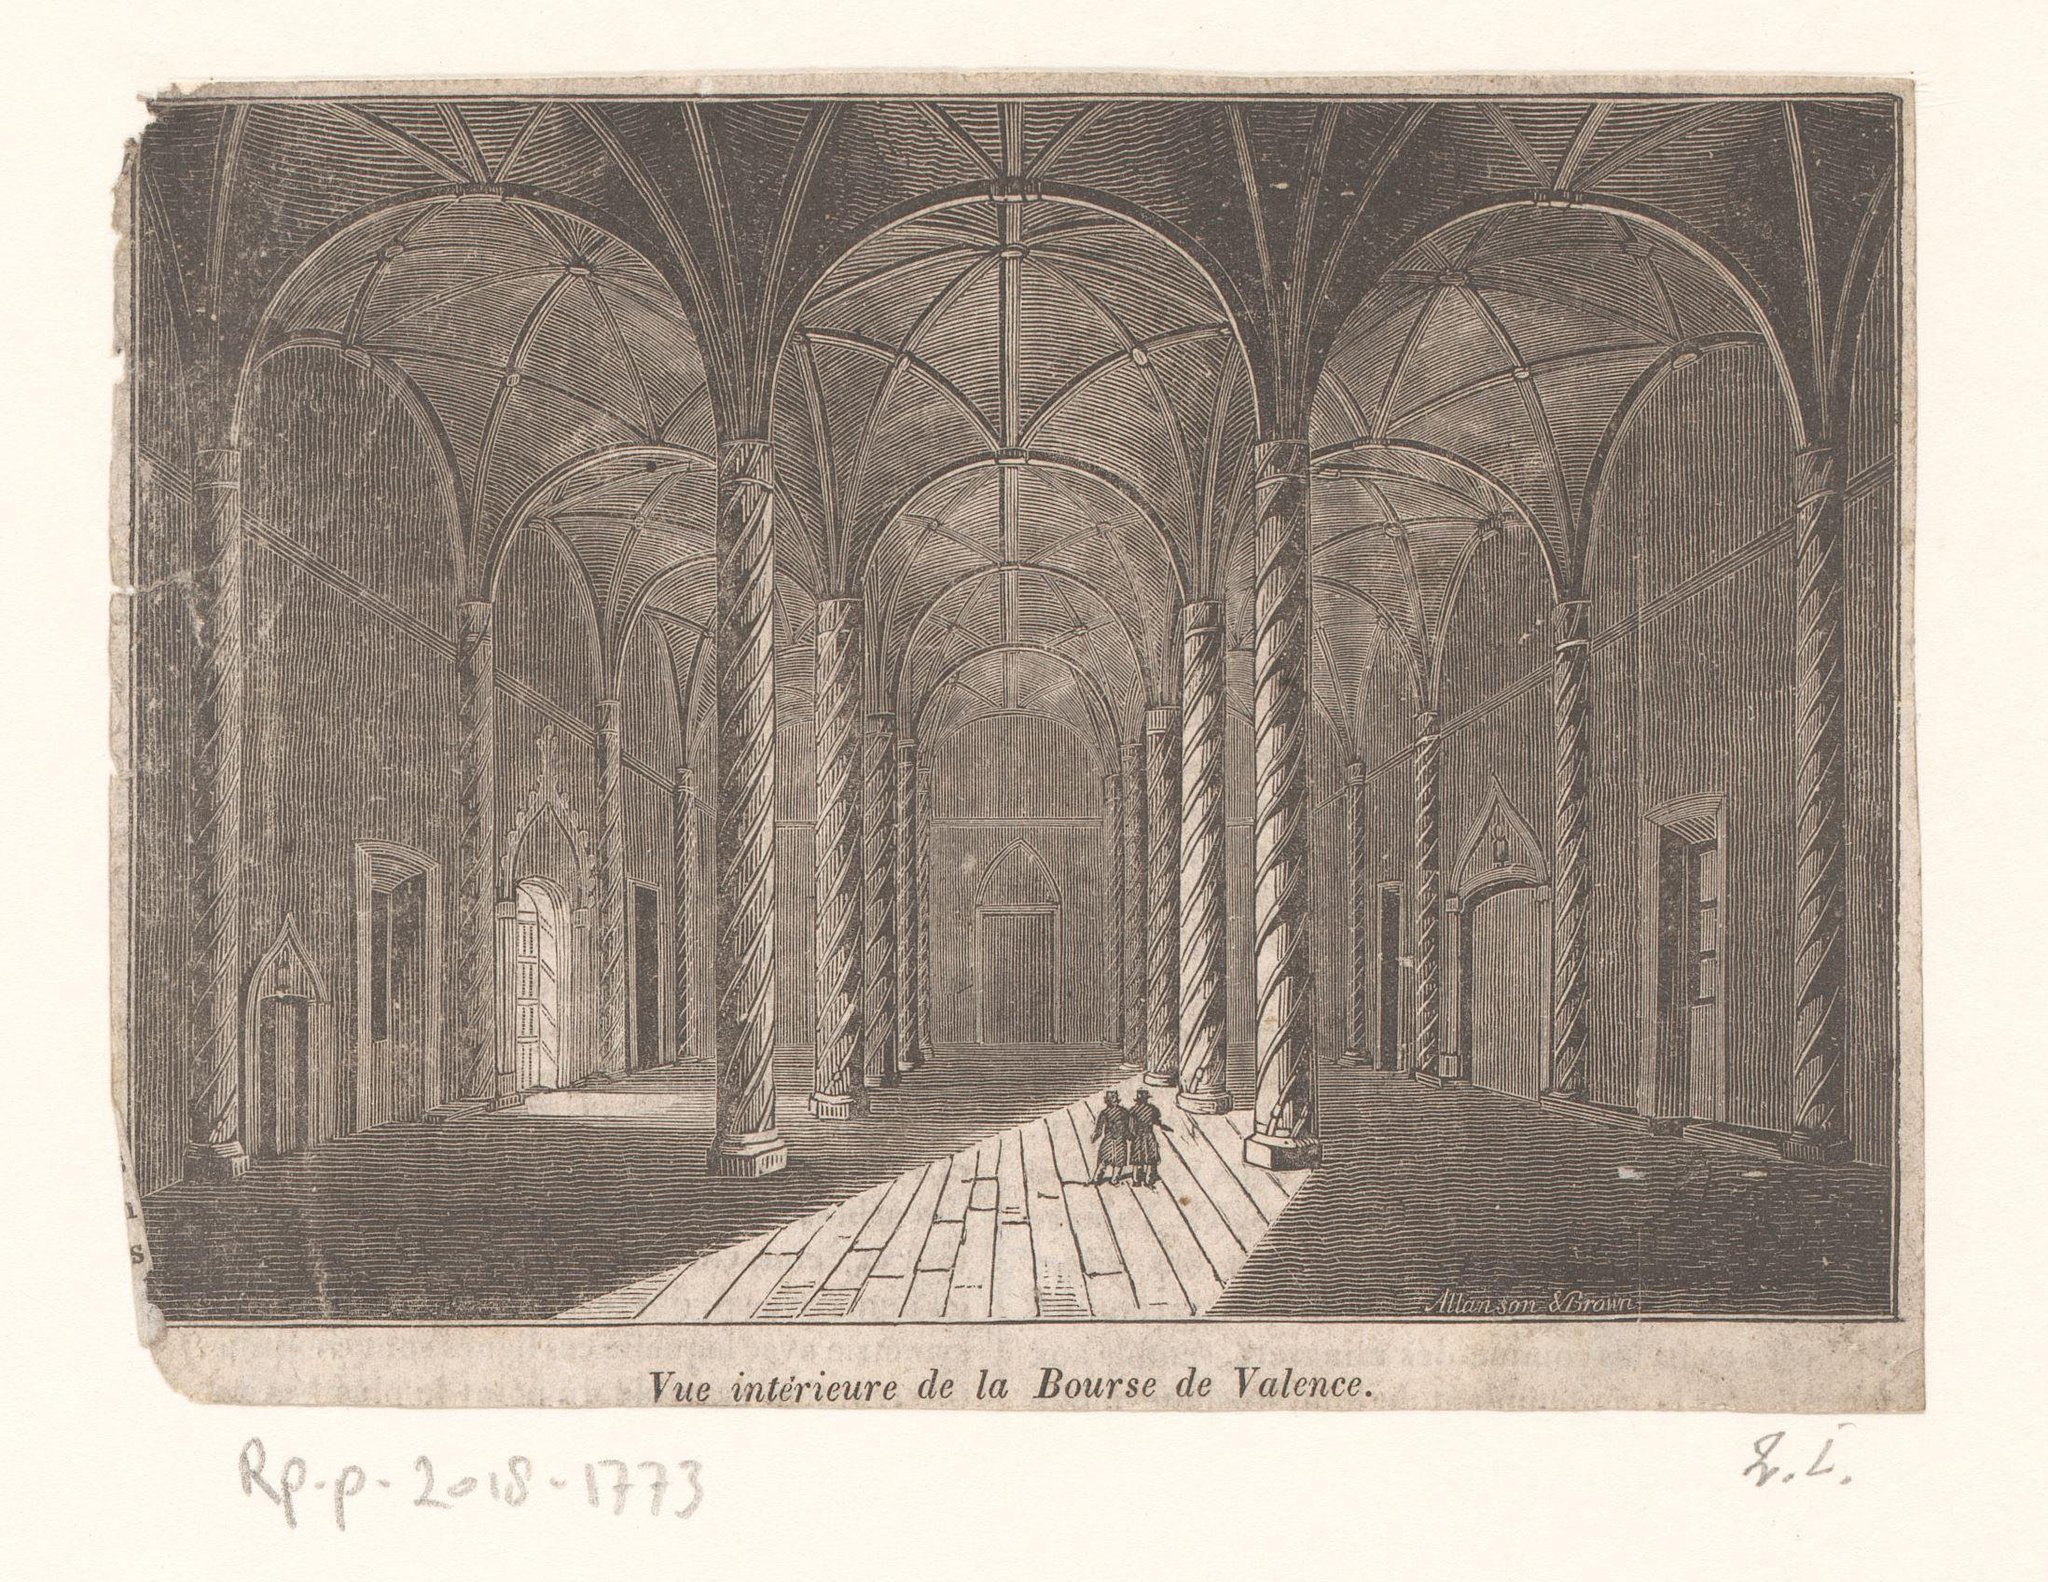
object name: print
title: Vue intérieure de la bourse de Valence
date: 1800-1899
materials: paper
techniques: letterpress printing, engraving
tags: exchange, bourse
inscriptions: collector's mark: Lugt 2228